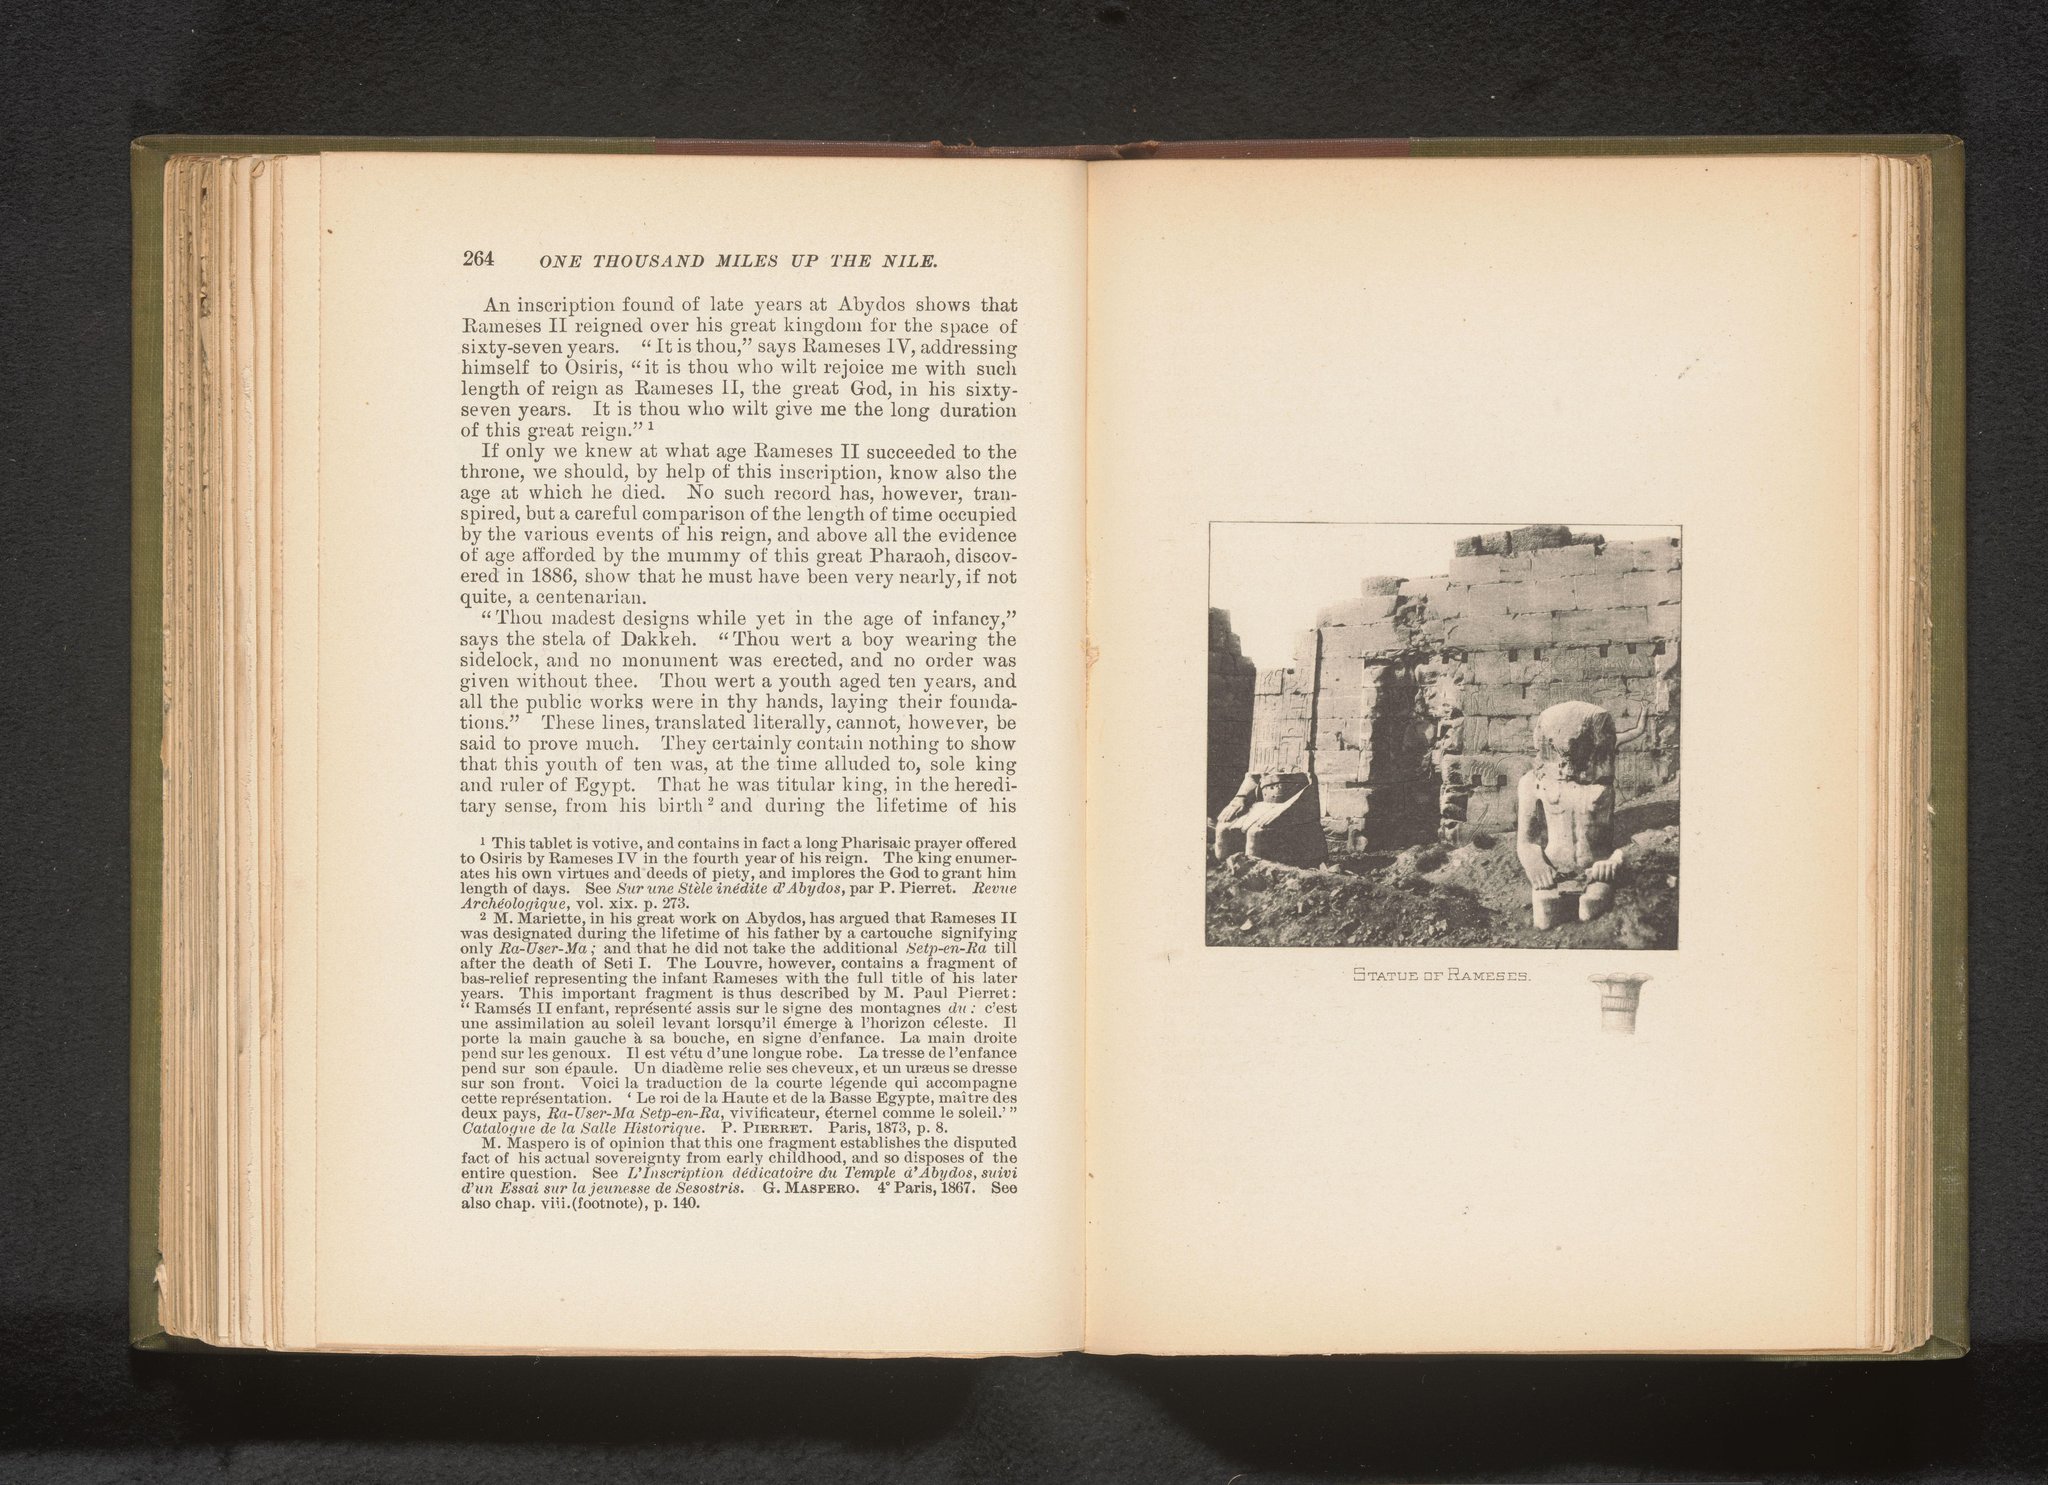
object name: photomechanical print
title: Statue of Rameses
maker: Anonymous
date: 1884-1894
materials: paper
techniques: photoaquatint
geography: egypt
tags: temple, shrine ~ egyptian religion, ruin of a building ~ architecture, sculpture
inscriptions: annotation